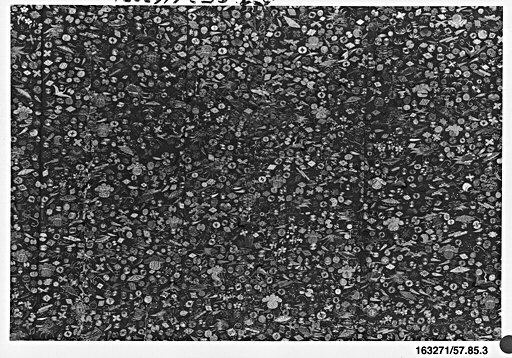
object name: hanging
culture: japanese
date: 1767-1800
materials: silk